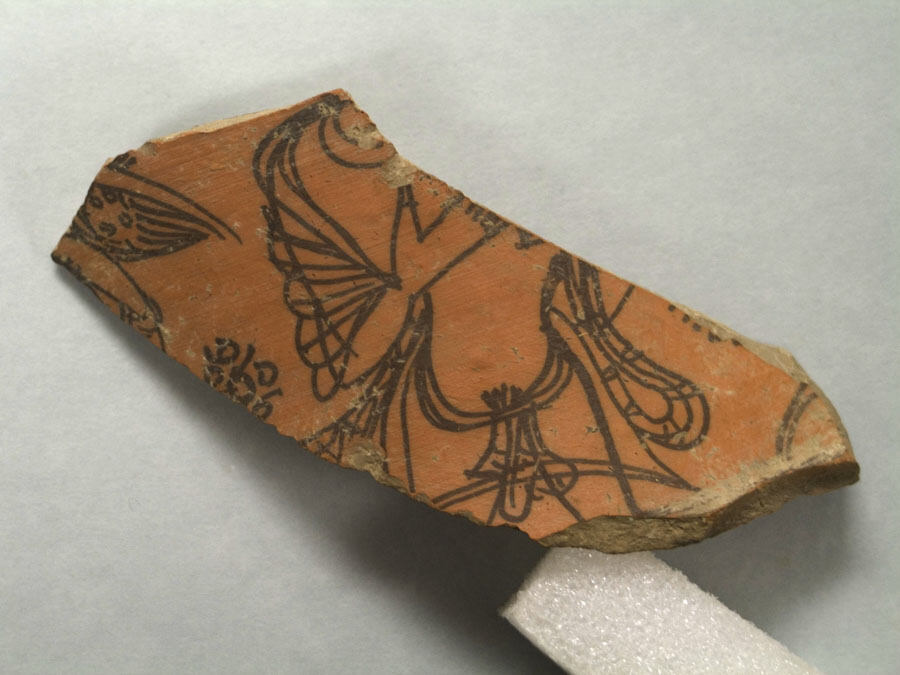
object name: shard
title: Shard: Torso of Offerer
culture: pakistani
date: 301-500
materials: terracotta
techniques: painting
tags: gandhara